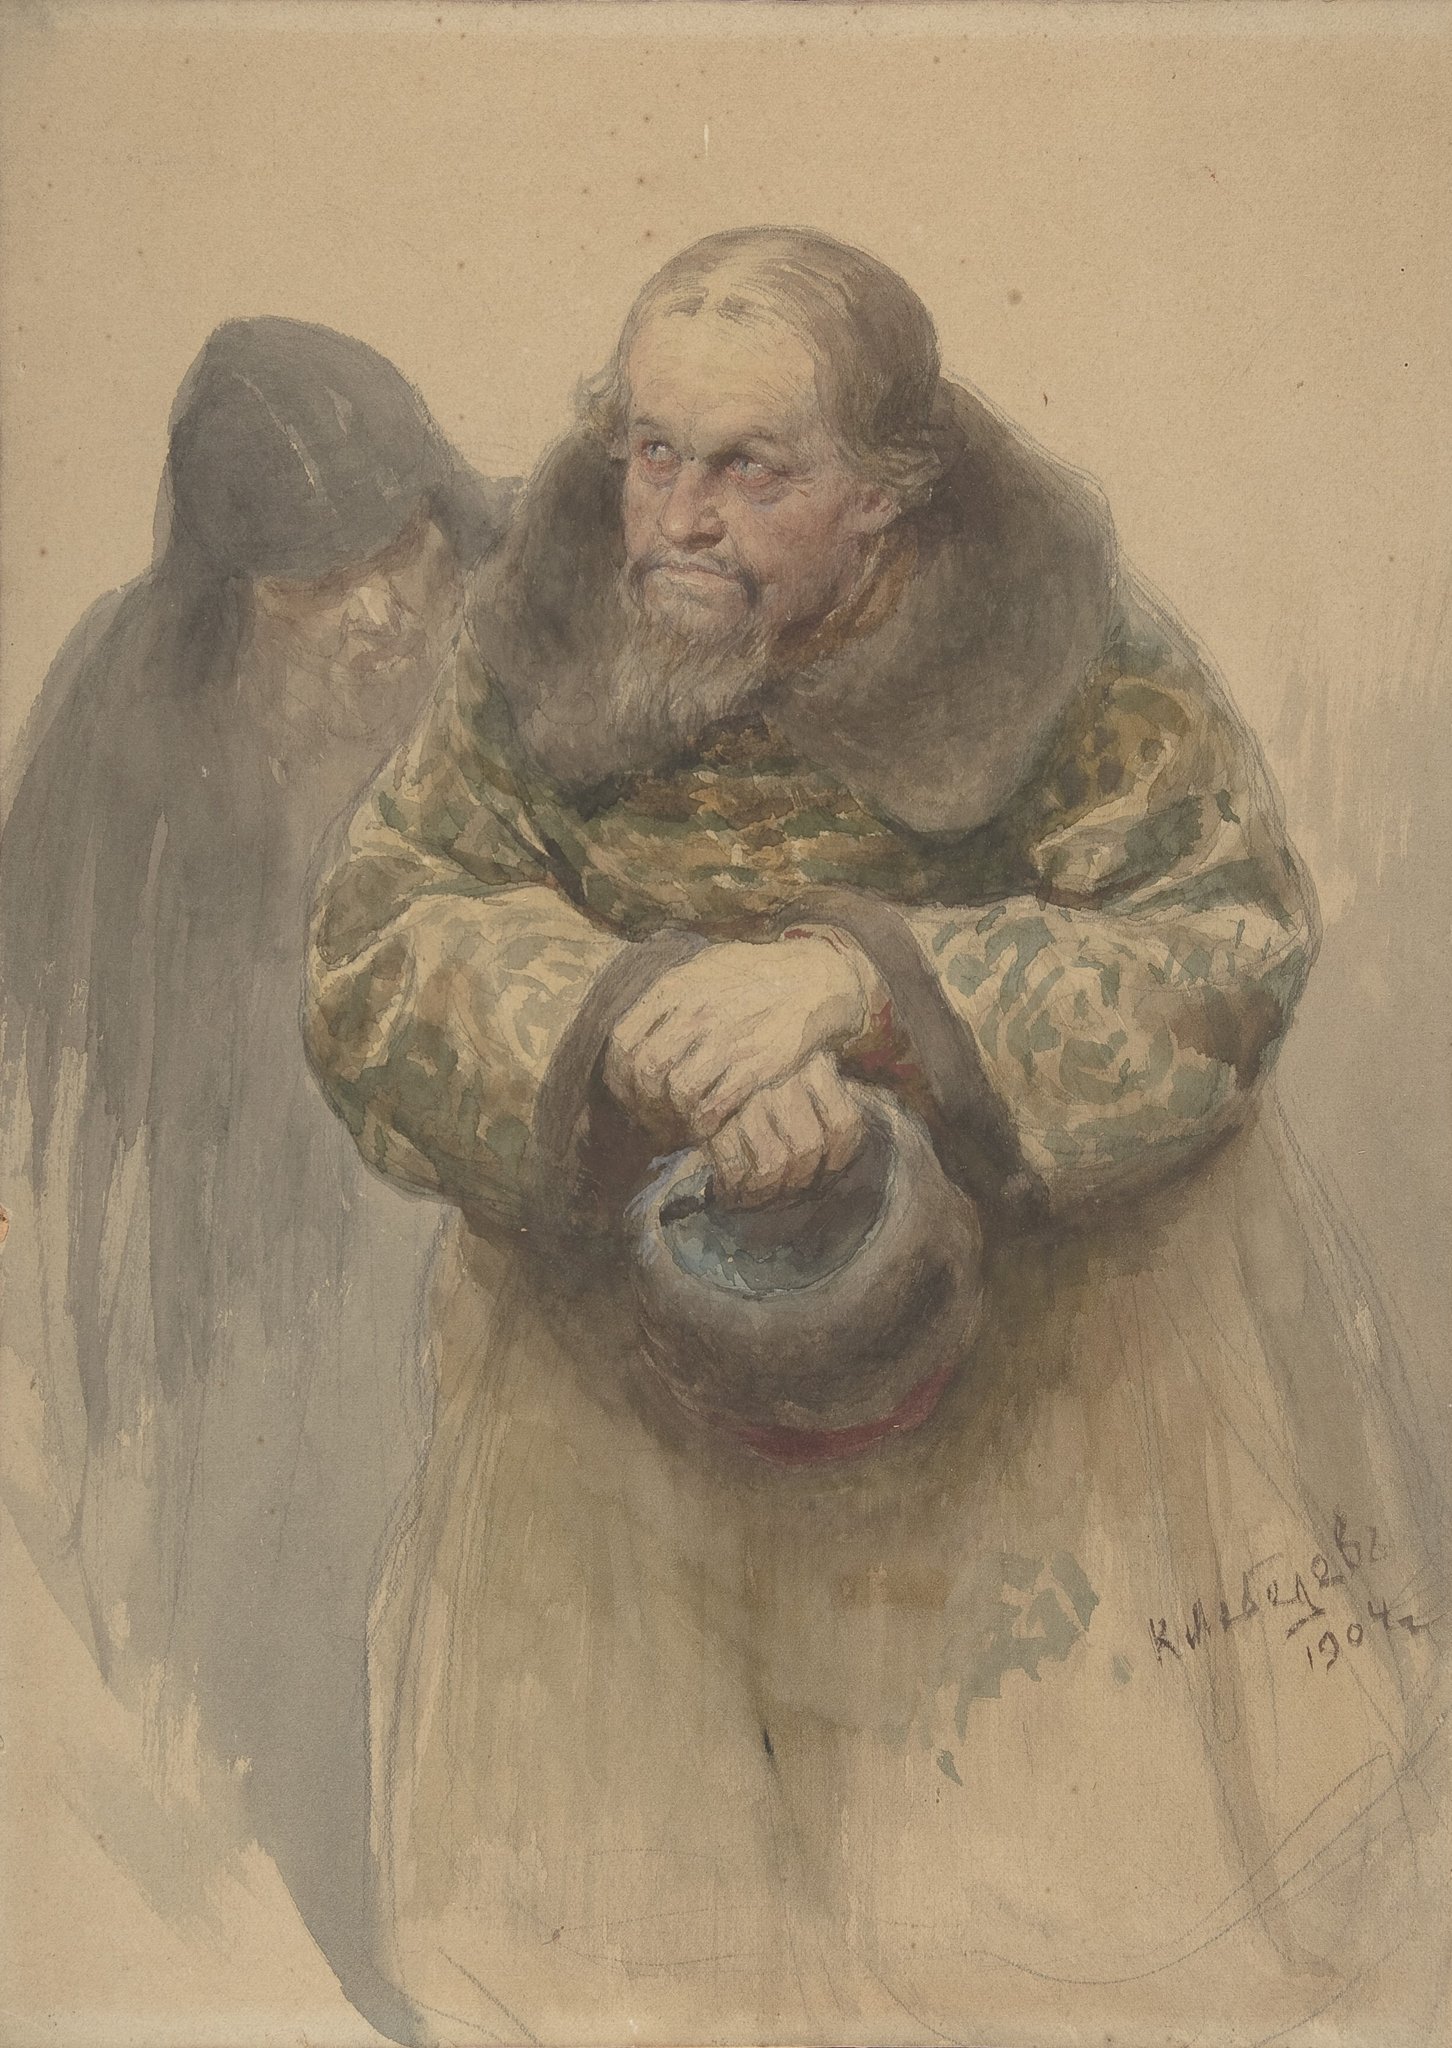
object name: drawing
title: Two Russian Men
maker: klavdy vasilyevich lebedev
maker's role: artist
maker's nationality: russian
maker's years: 1852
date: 1904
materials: pencil, watercolor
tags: men